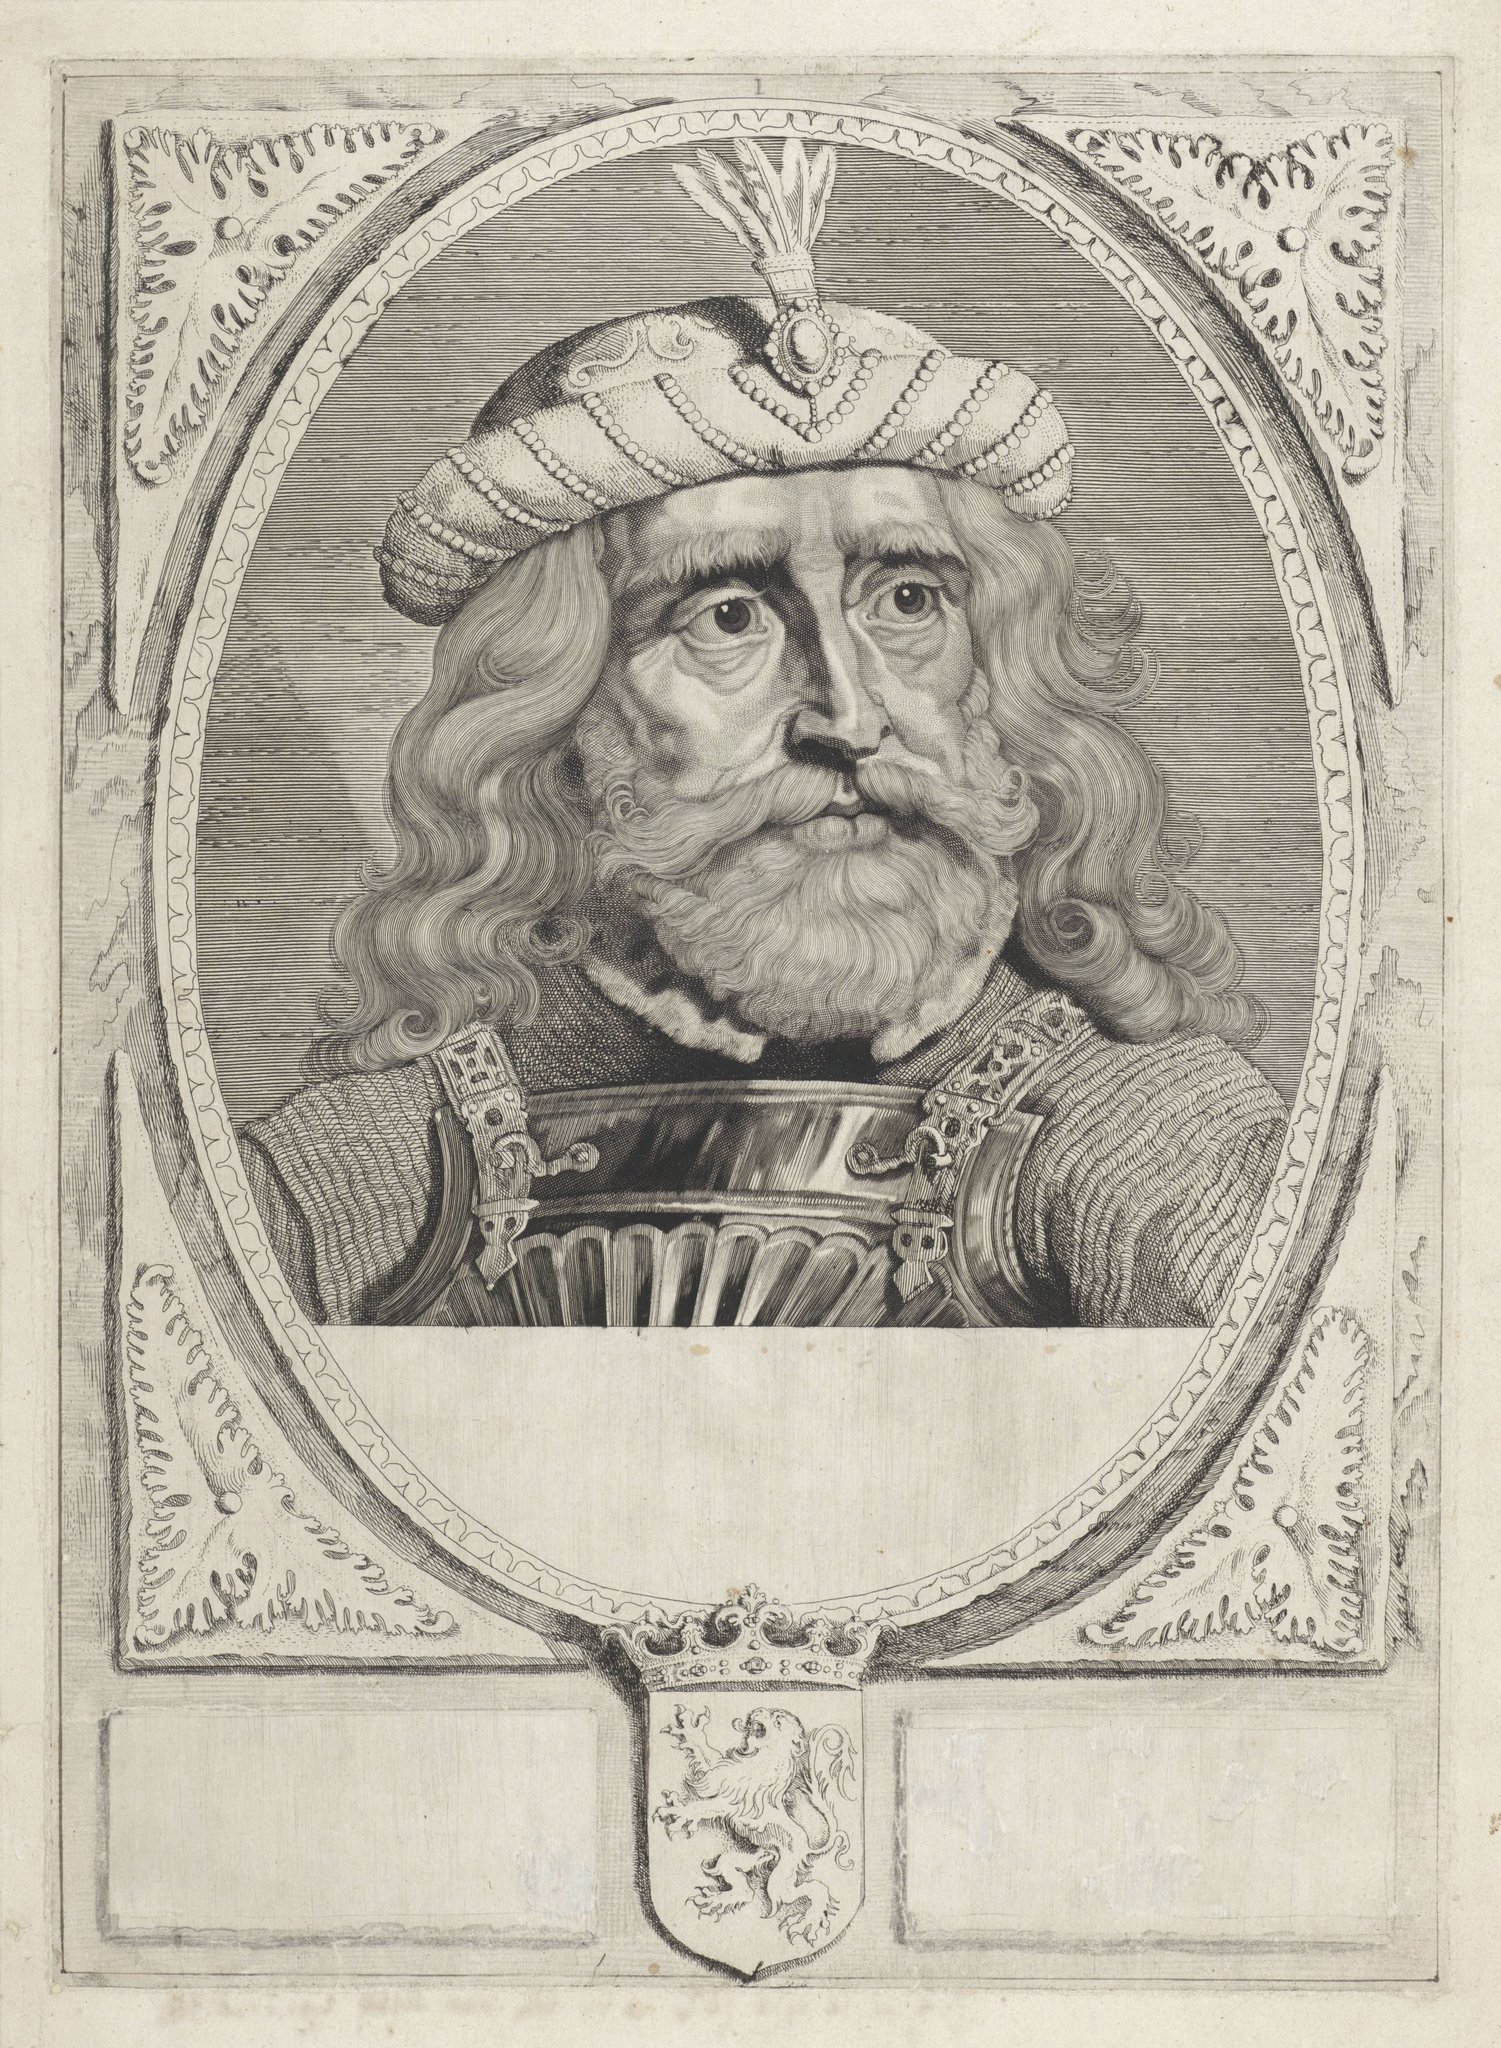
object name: print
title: Portret van Dirk I, graaf van Holland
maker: cornelis visscher (ii)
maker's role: draughtsman, painter, print maker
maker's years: 1628-1658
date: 1650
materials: paper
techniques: engraving, etching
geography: haarlem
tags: nobility and patriciate; chivalry, knighthood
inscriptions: collector's mark: Lugt 240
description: Proefdruk van de eerste prent uit een de serie 'Graven en gravinnen van Holland, Zeeland en West-Friesland', bestaande uit 38 prenten.